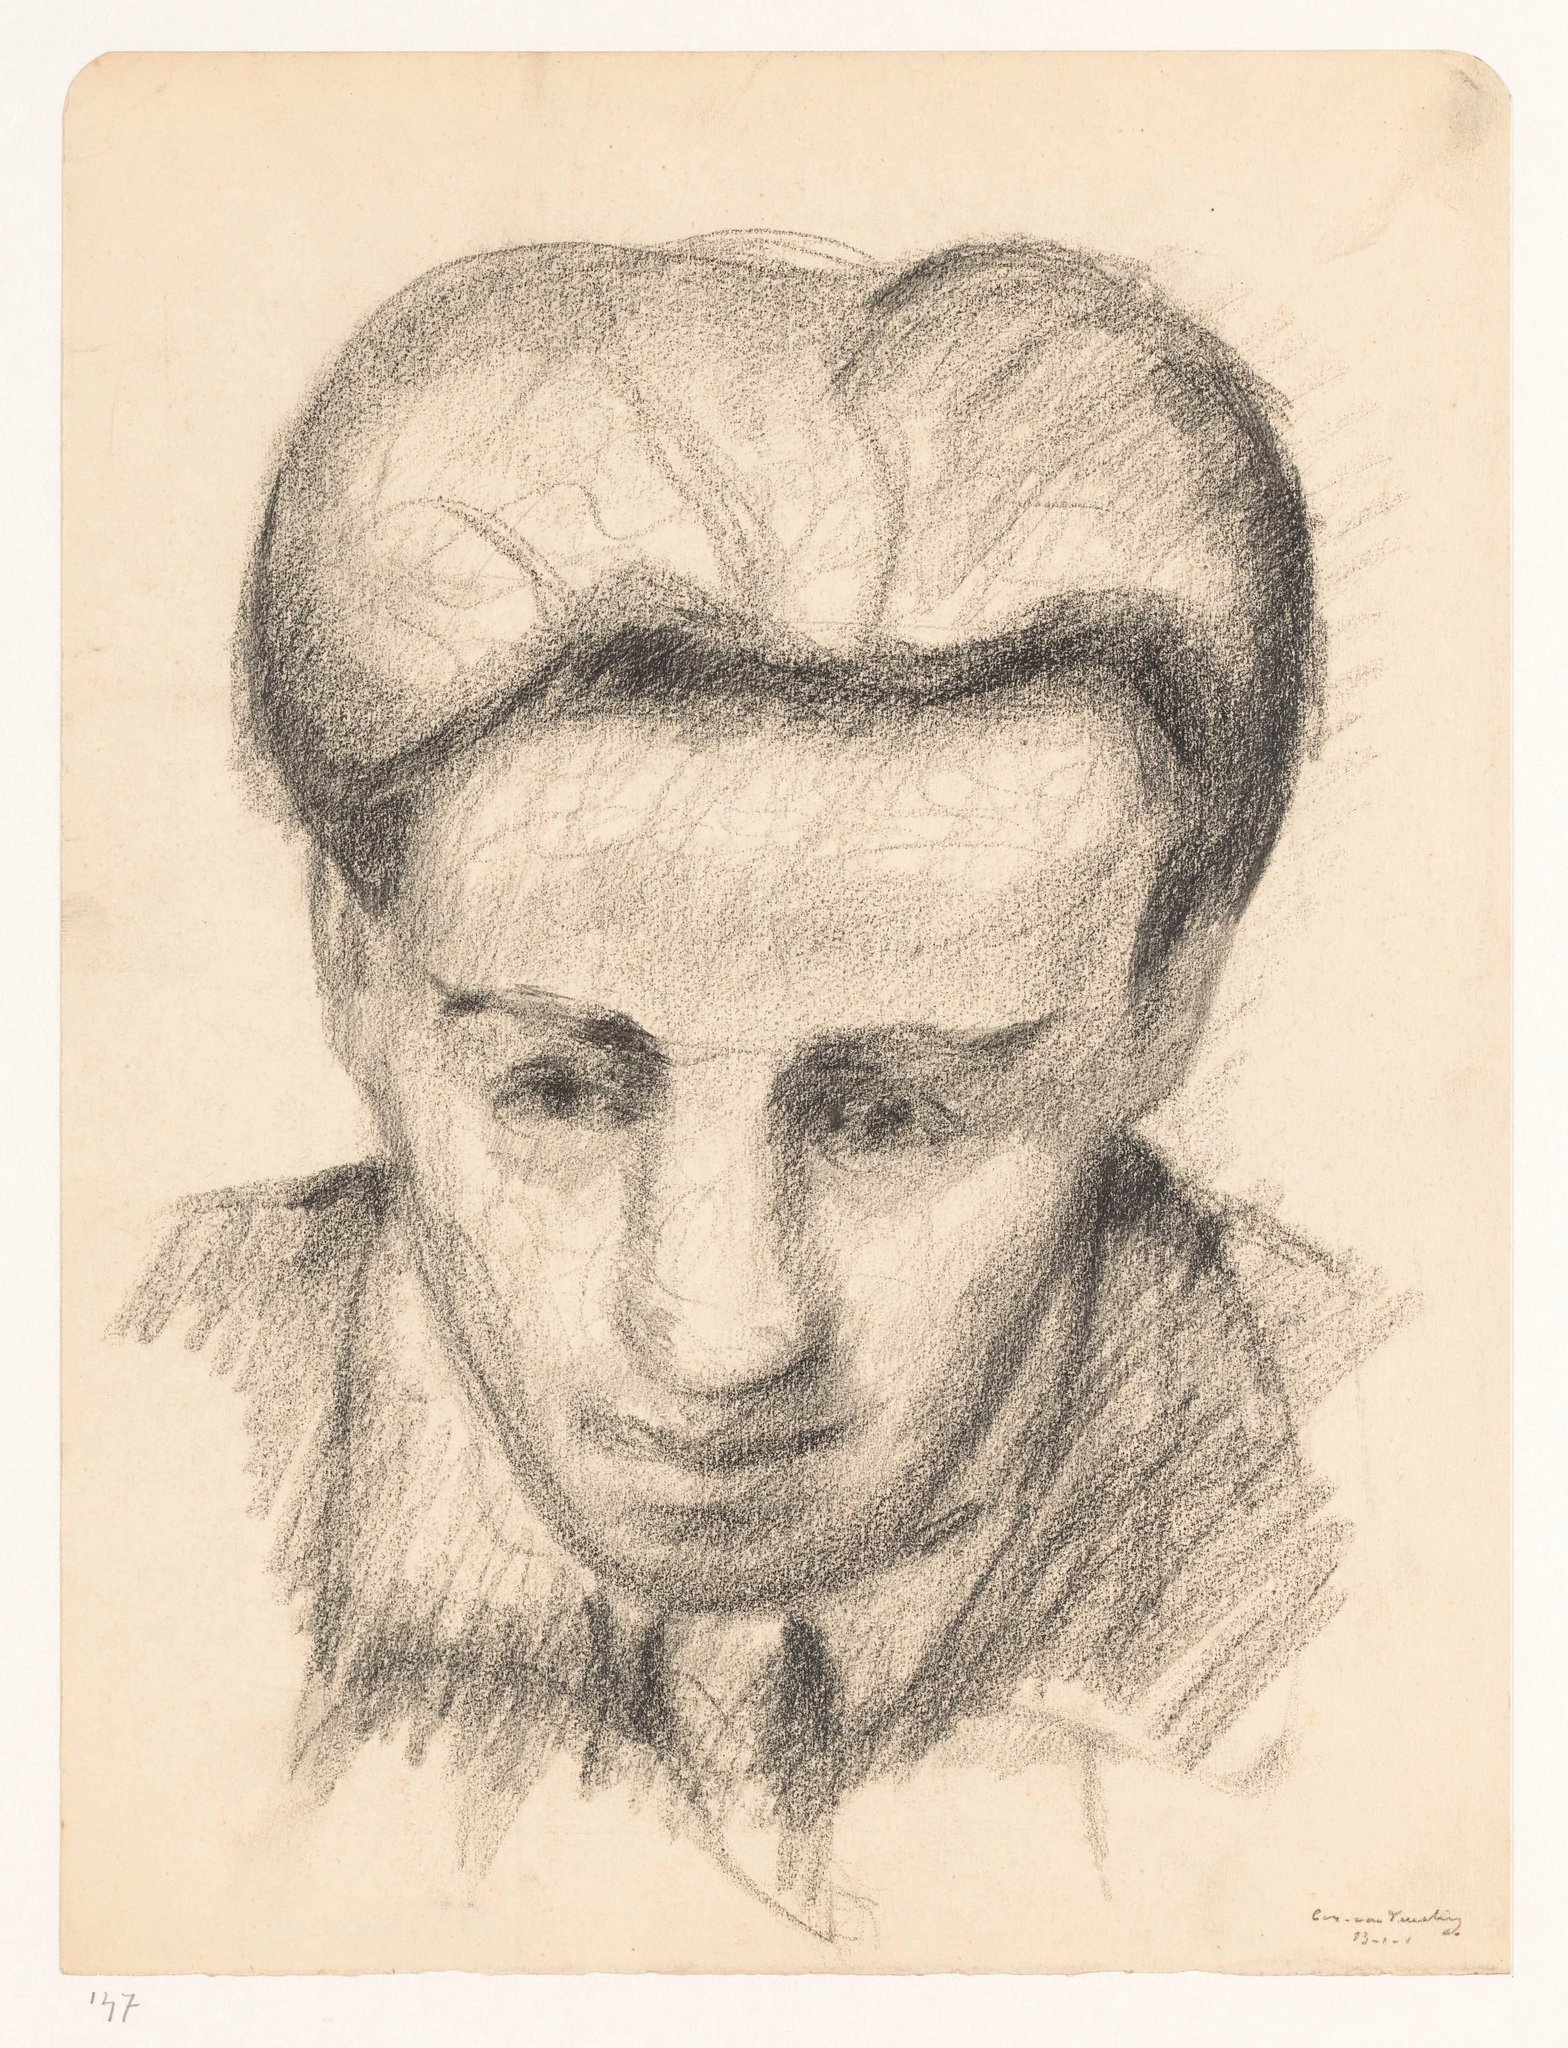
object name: drawing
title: Zelfportretten van Cor van Teeseling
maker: cor van teeseling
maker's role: draughtsman, sculptor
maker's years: 1915-1942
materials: chalk, paper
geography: weteringschans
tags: amsterdam, draughtsman, sculptor, cor van teeseling, historical persons, prisoner in cell or locked place, portrait, self-portrait of draughtsman, netherlands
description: Zelfportret van voorovergebogen Cor van Teeseling en face: B-1-1.